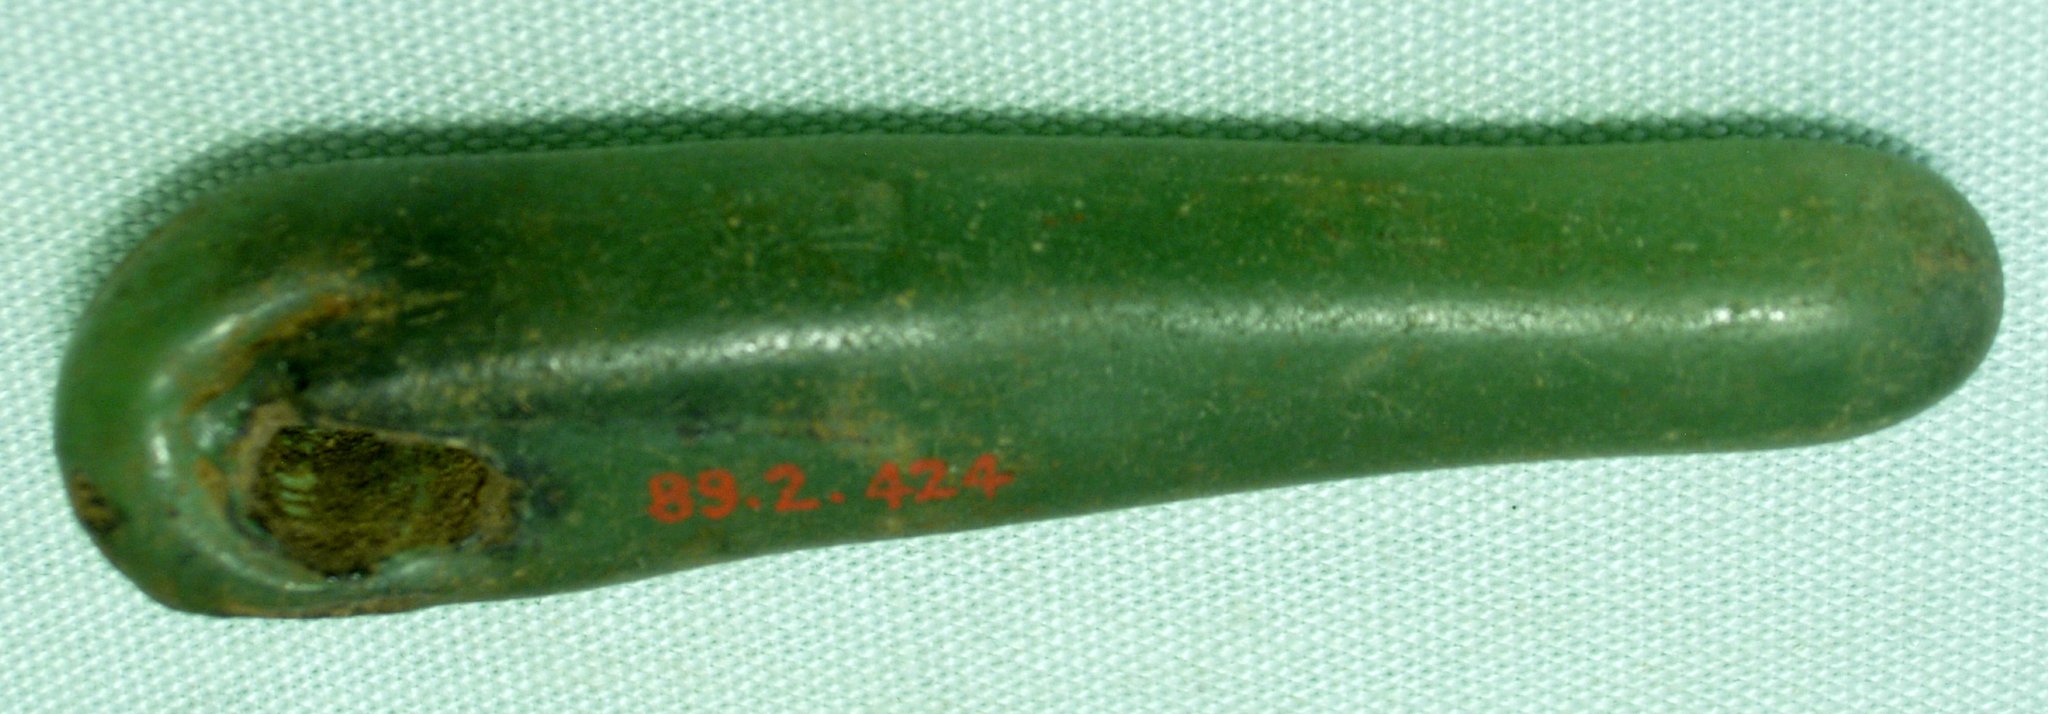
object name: pendant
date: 801-1400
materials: glass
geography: egypt